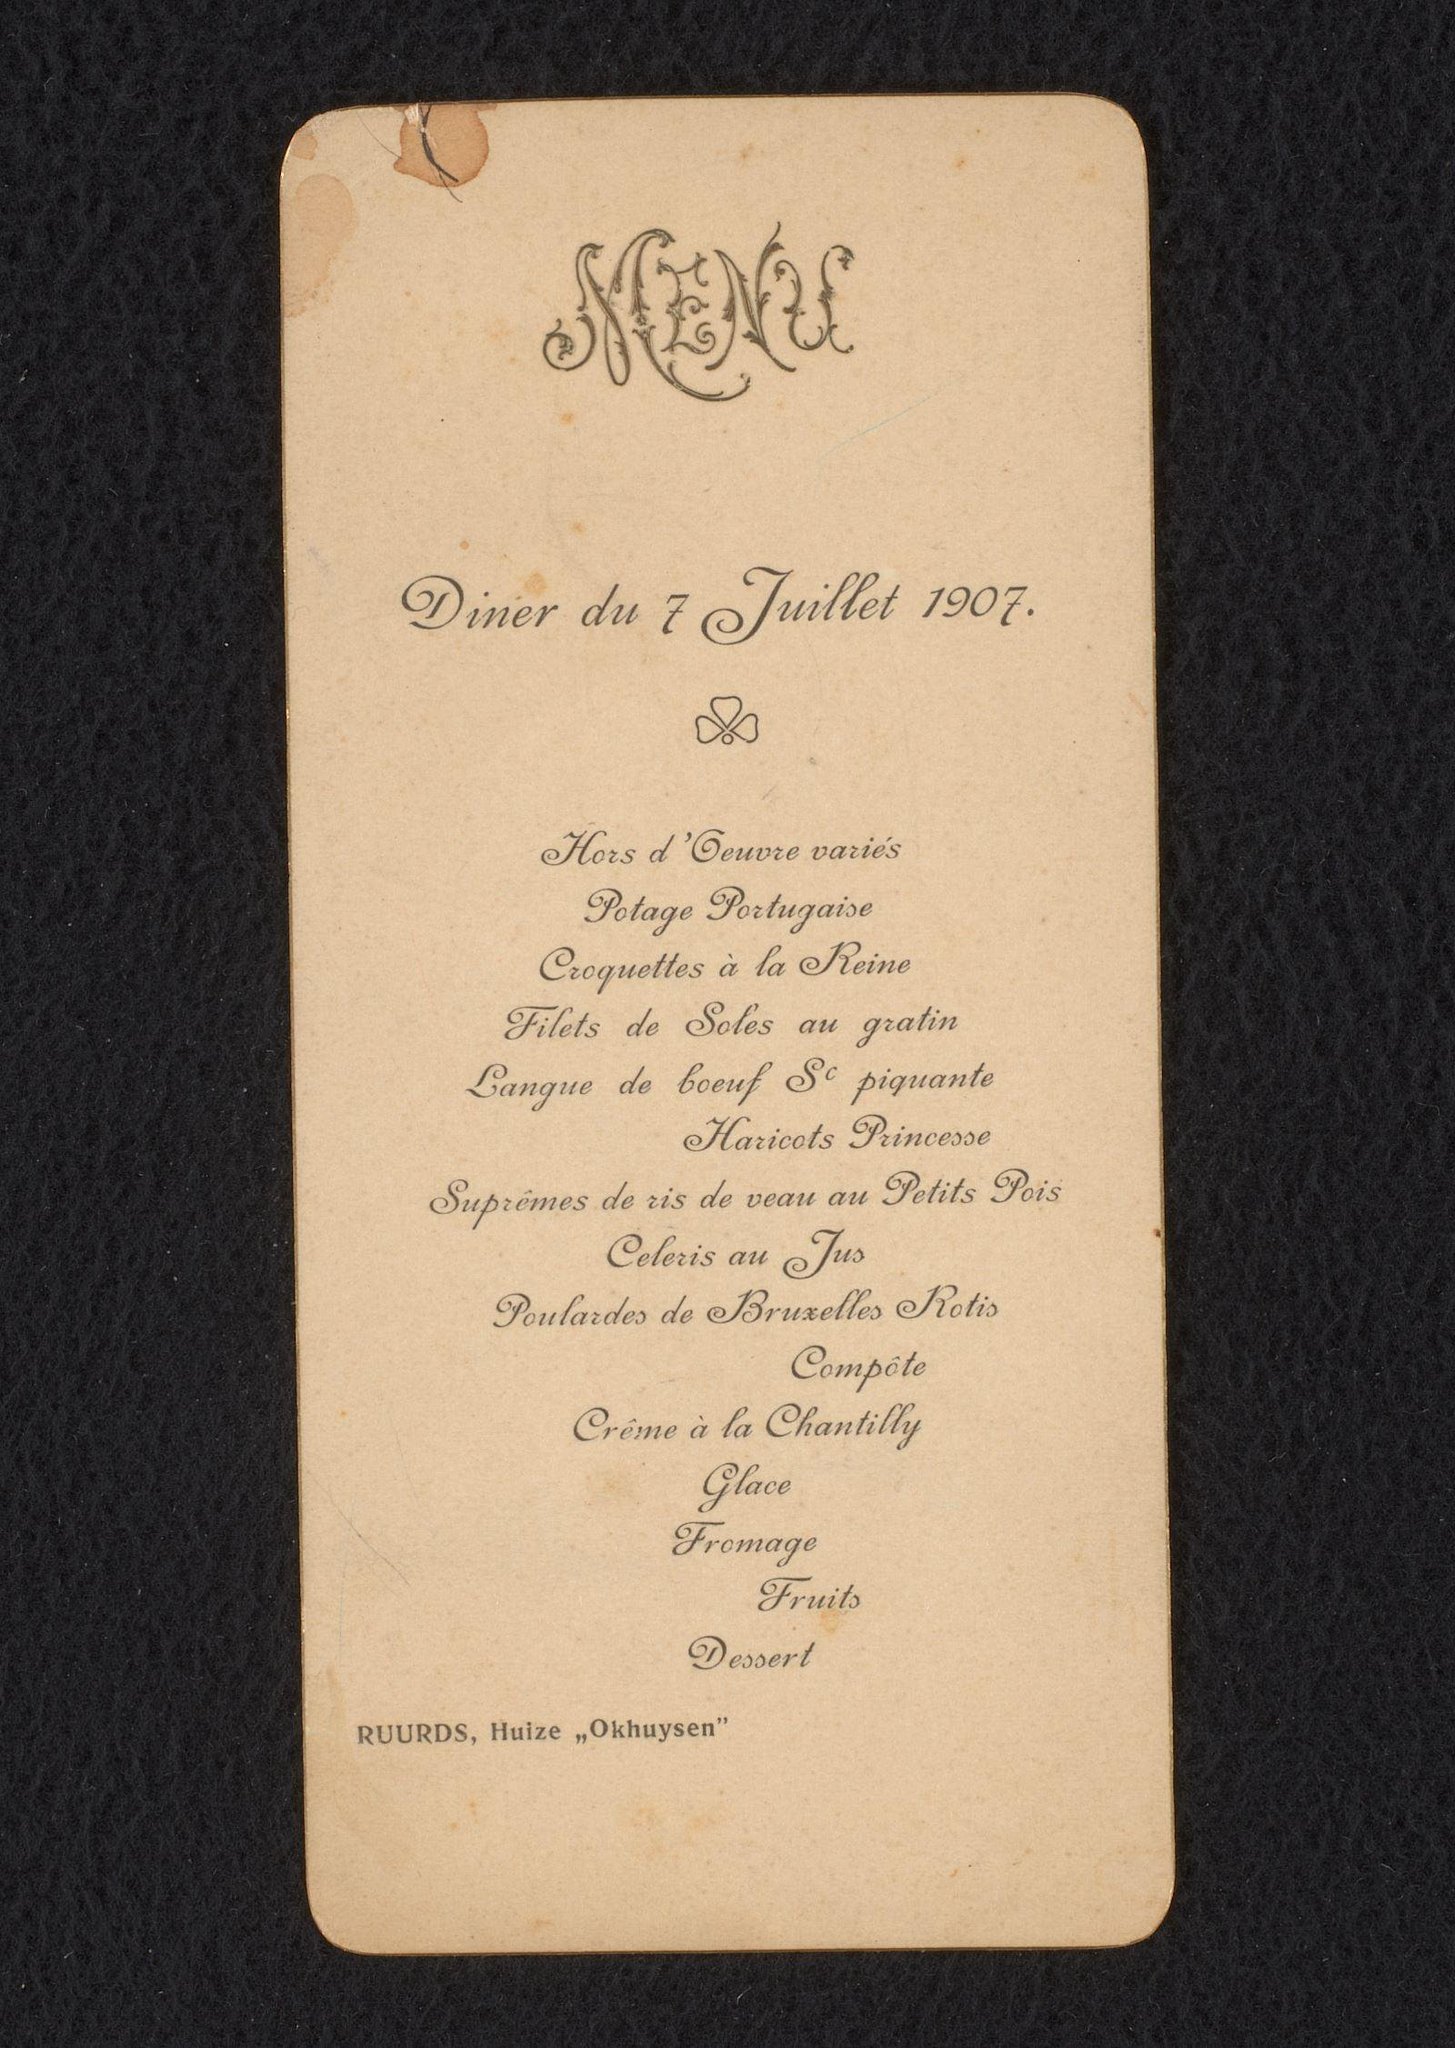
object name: menu, menukaart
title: Menukaart voor een diner in Huize Okhuysen op 7 juli 1907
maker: Anonymous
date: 1907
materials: paper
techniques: printing, letterpress printing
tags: 43b311(+12)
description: Typografische kaart met bovenaan het woord 'Menu' in een decoratieve letter. Daaronder het menu voor het diner op 7 juli 1907. Verder staat nog de naam 'Ruurds' vermeld, mogelijk de kok van Huize Okhuysen.